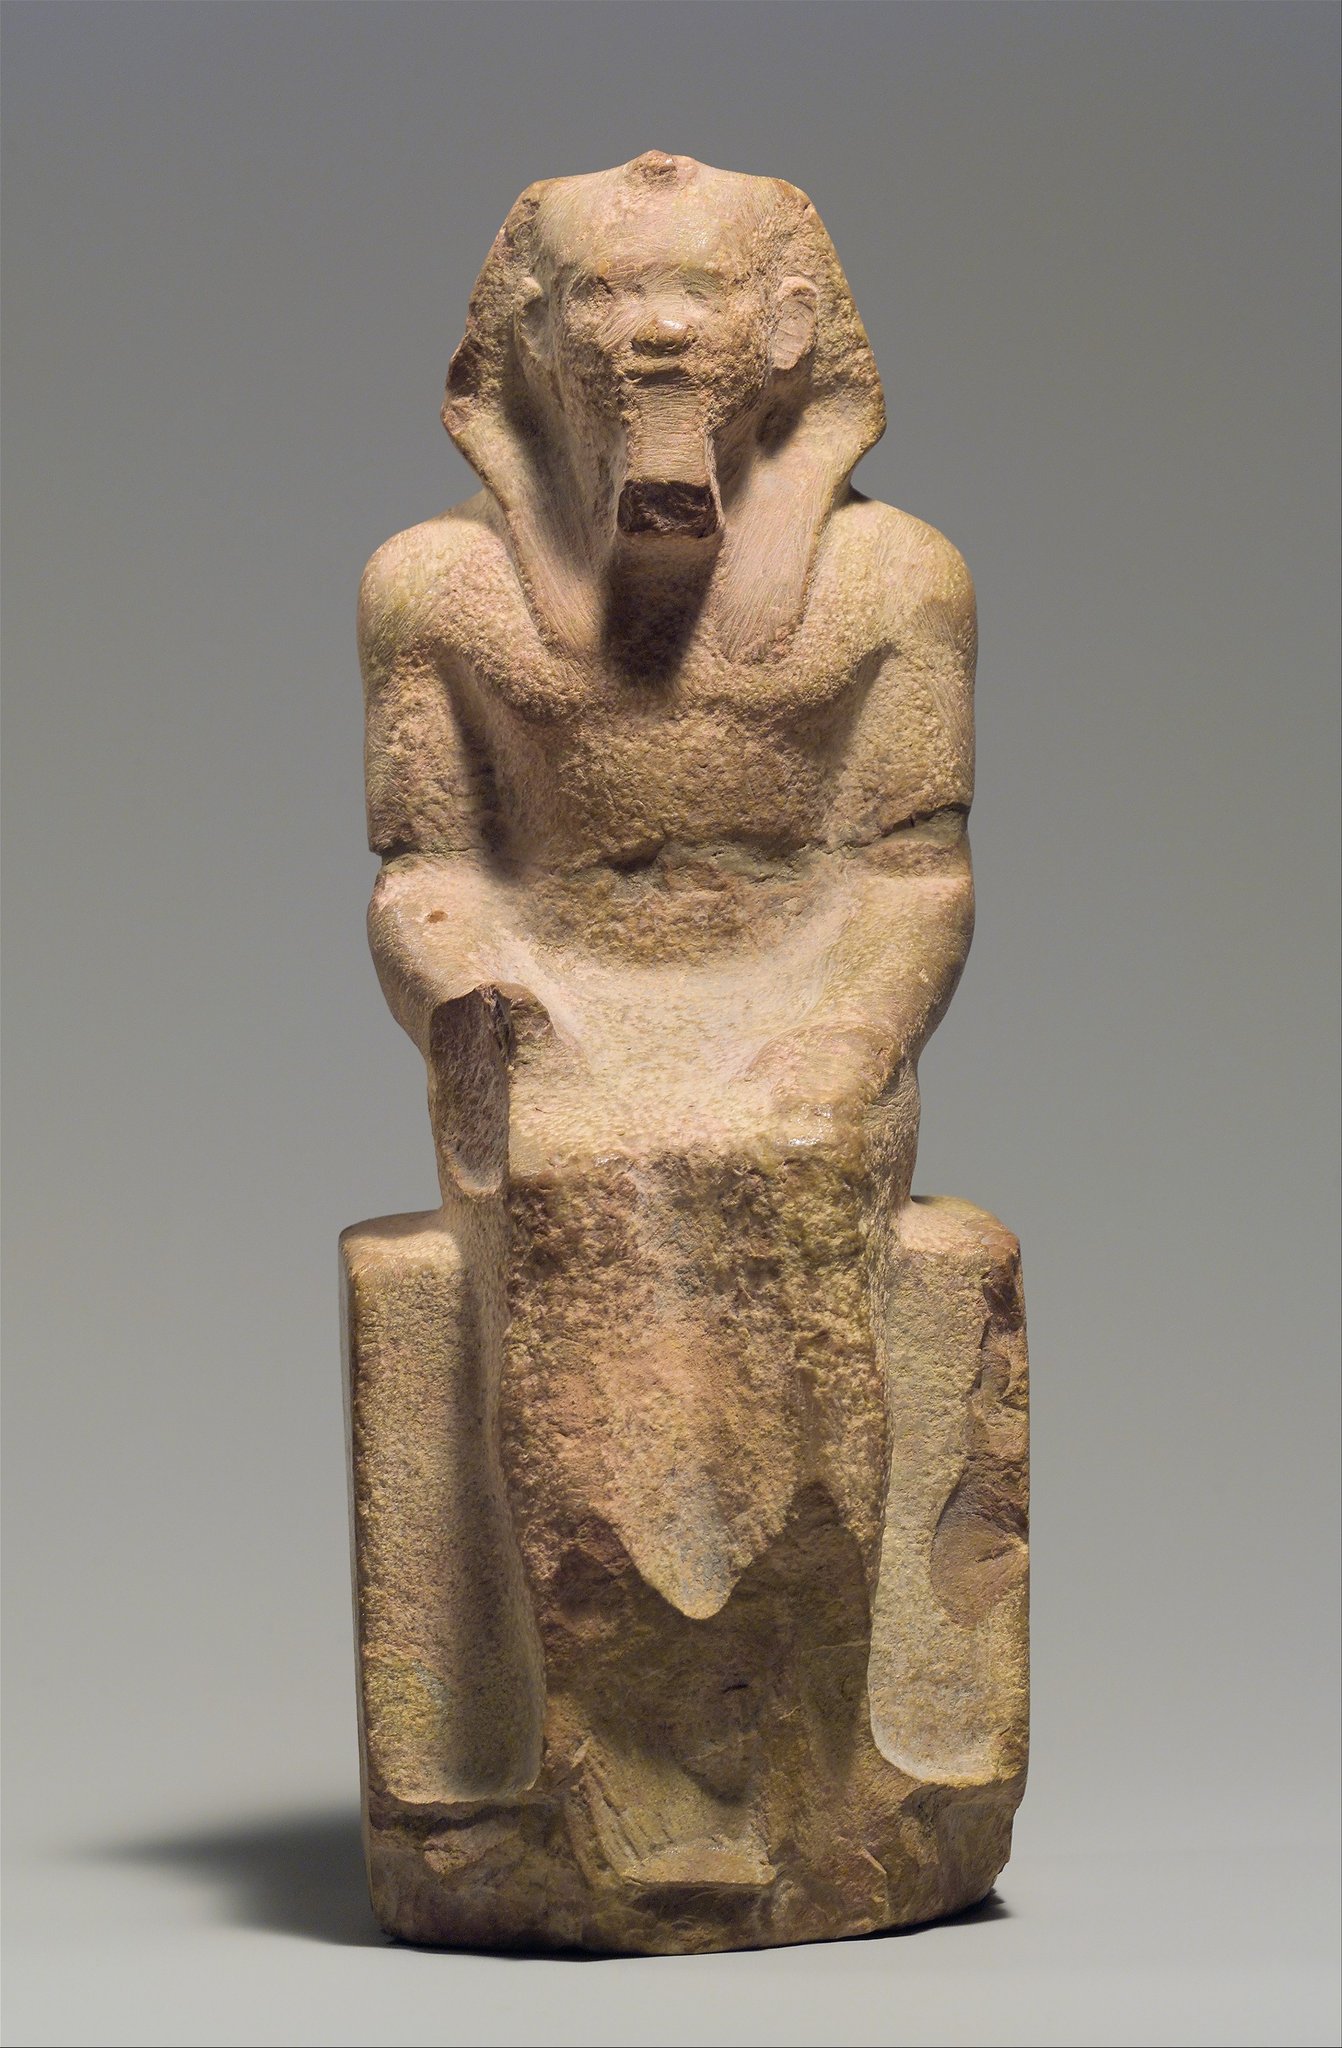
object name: statue, menkaure seated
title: Seated Statue of King Menkaure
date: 2490-2472 BCE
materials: limestone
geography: egypt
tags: kings